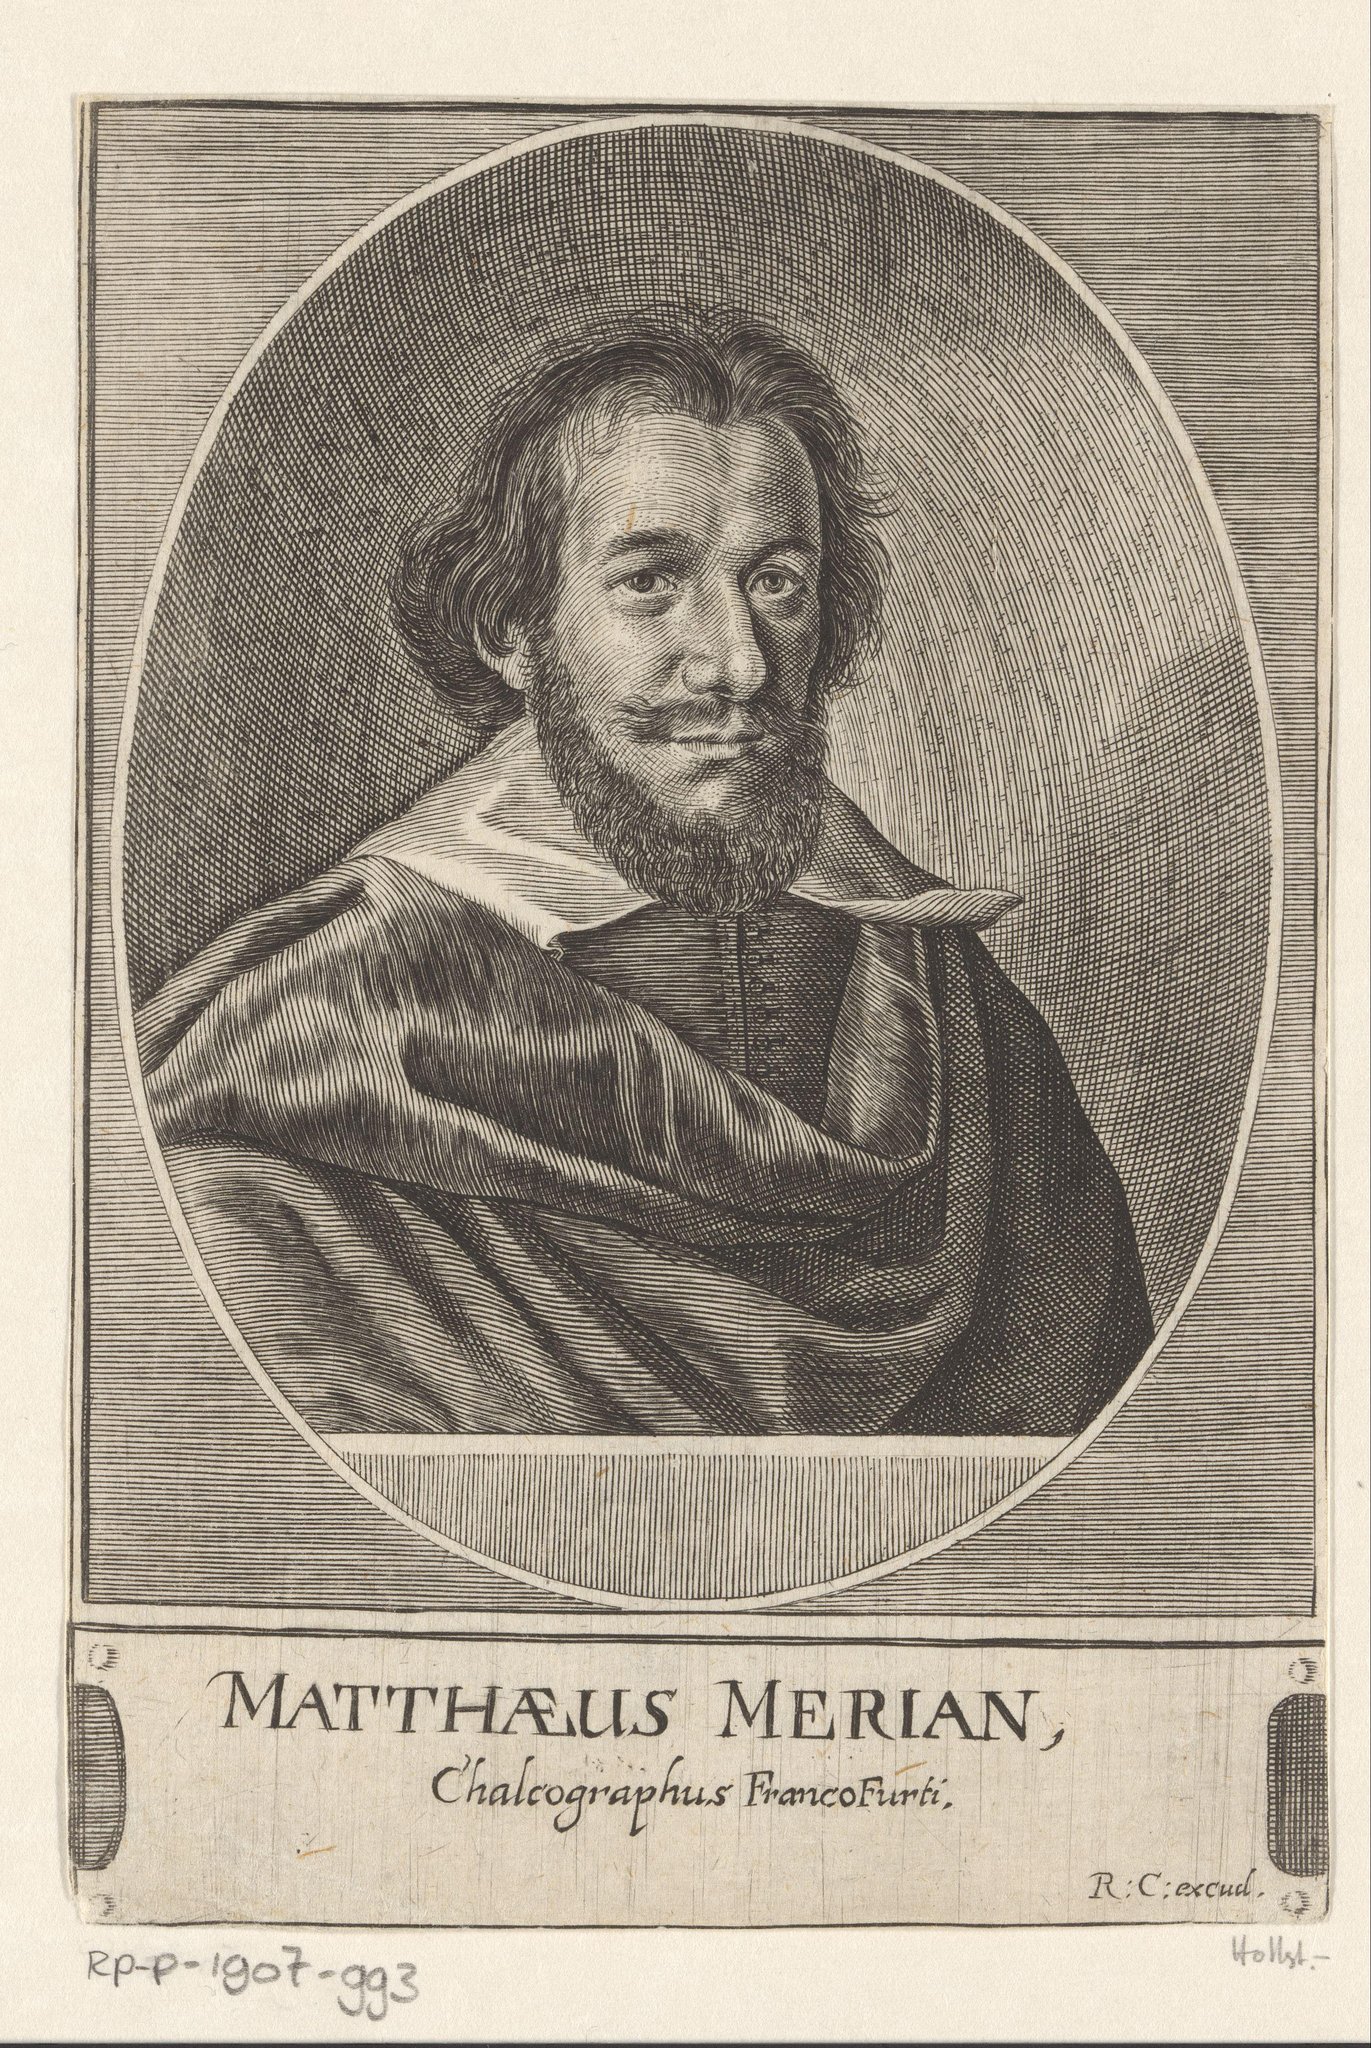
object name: print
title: Portret van Matthaeus Merian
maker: raphael custos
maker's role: print maker, publisher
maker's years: 1590-1664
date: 1600-1650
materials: paper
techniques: engraving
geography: augsburg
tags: historical persons, portrait, self-portrait of graphic artist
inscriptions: collector's mark: Lugt 2228